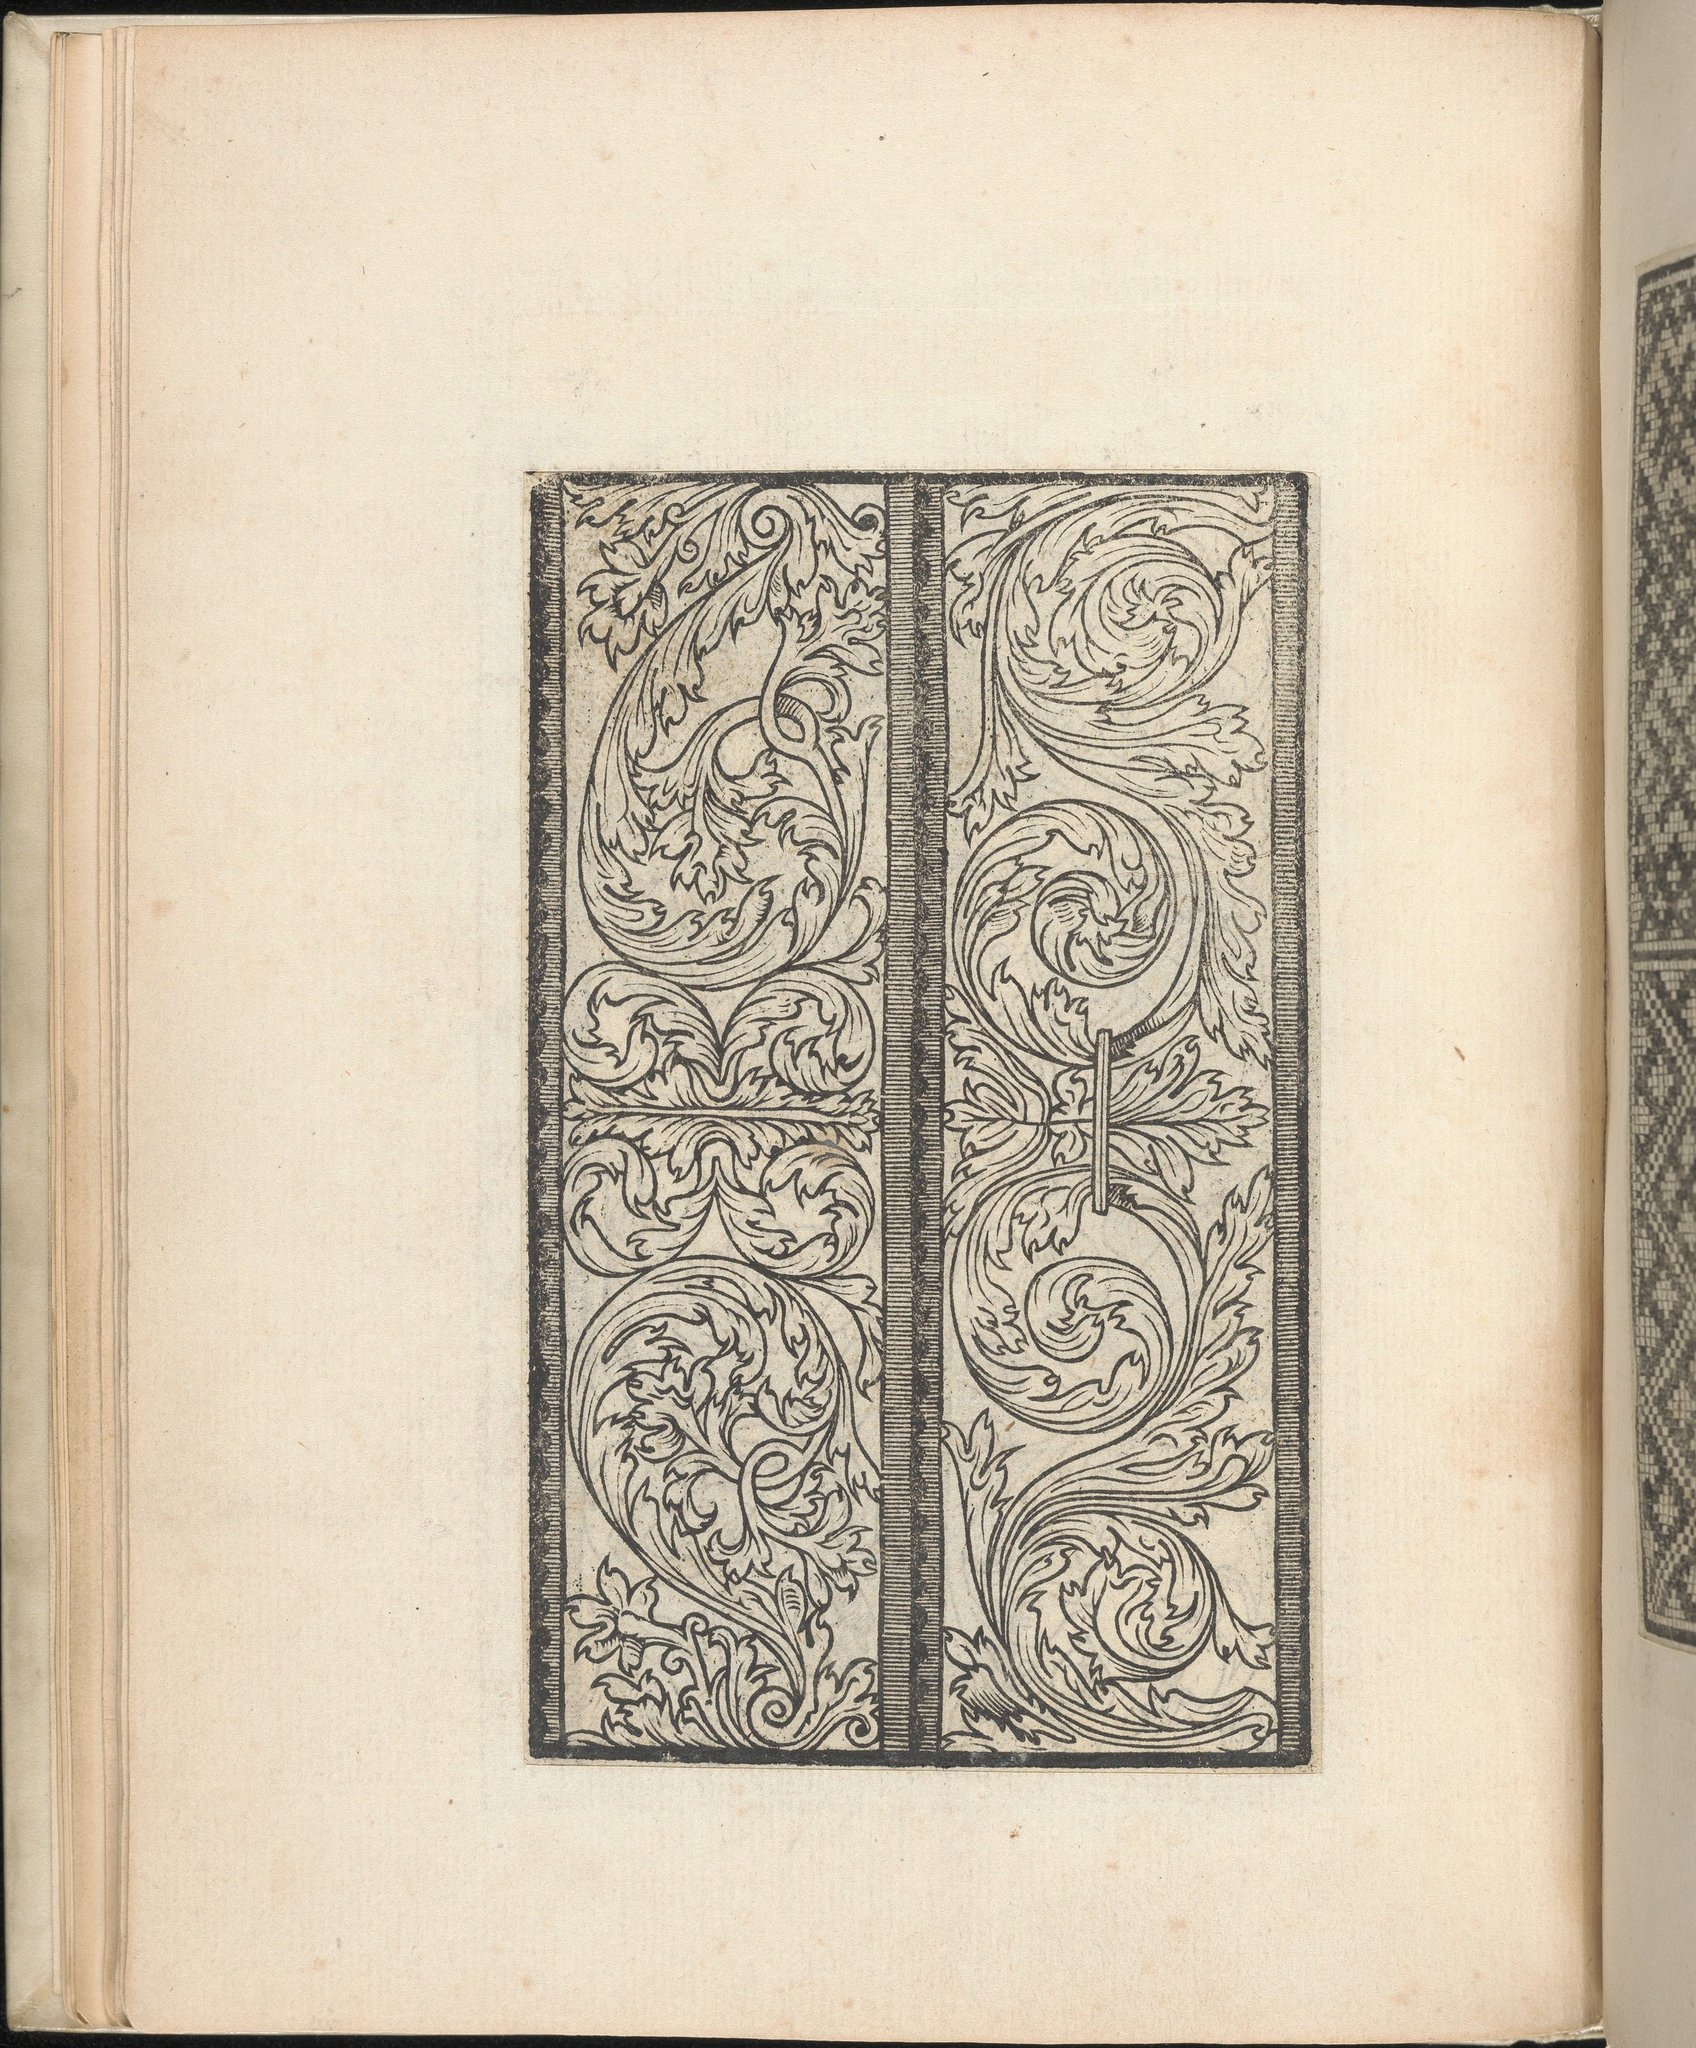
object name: book print ornament architecture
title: Esemplario di lavori, page 6 (verso)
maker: nicolò zoppino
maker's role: publisher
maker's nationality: italian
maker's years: 1478-1544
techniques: bookbinding, inlay, woodcut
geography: italy